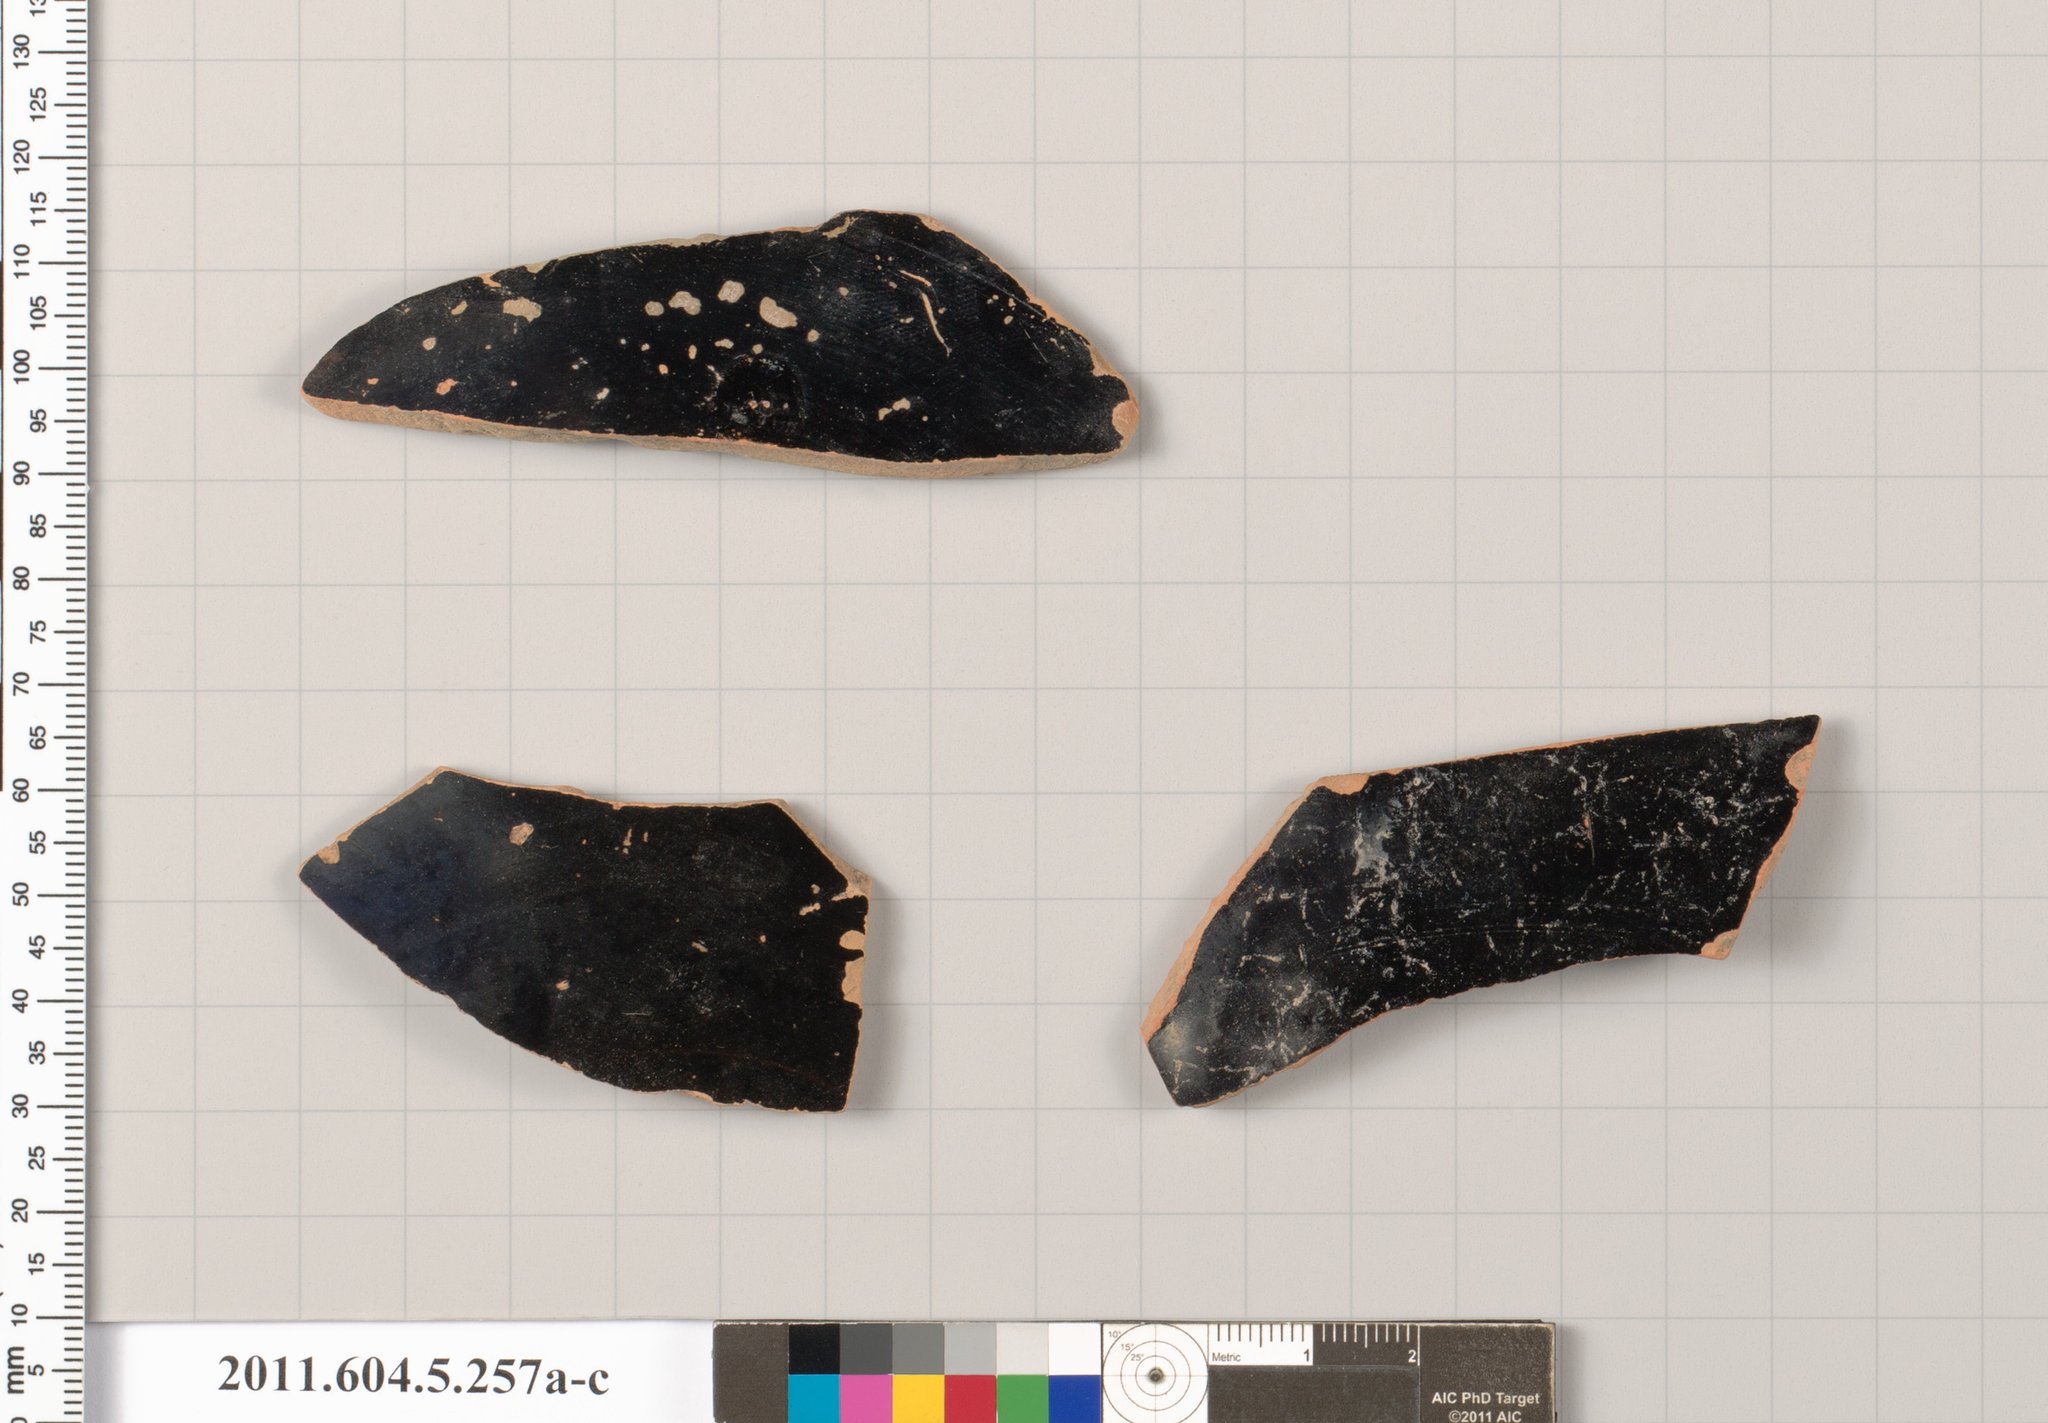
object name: kylix fragment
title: Terracotta fragments of kylikes (drinking cups)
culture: greek, attic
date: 600-401 BCE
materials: terracotta